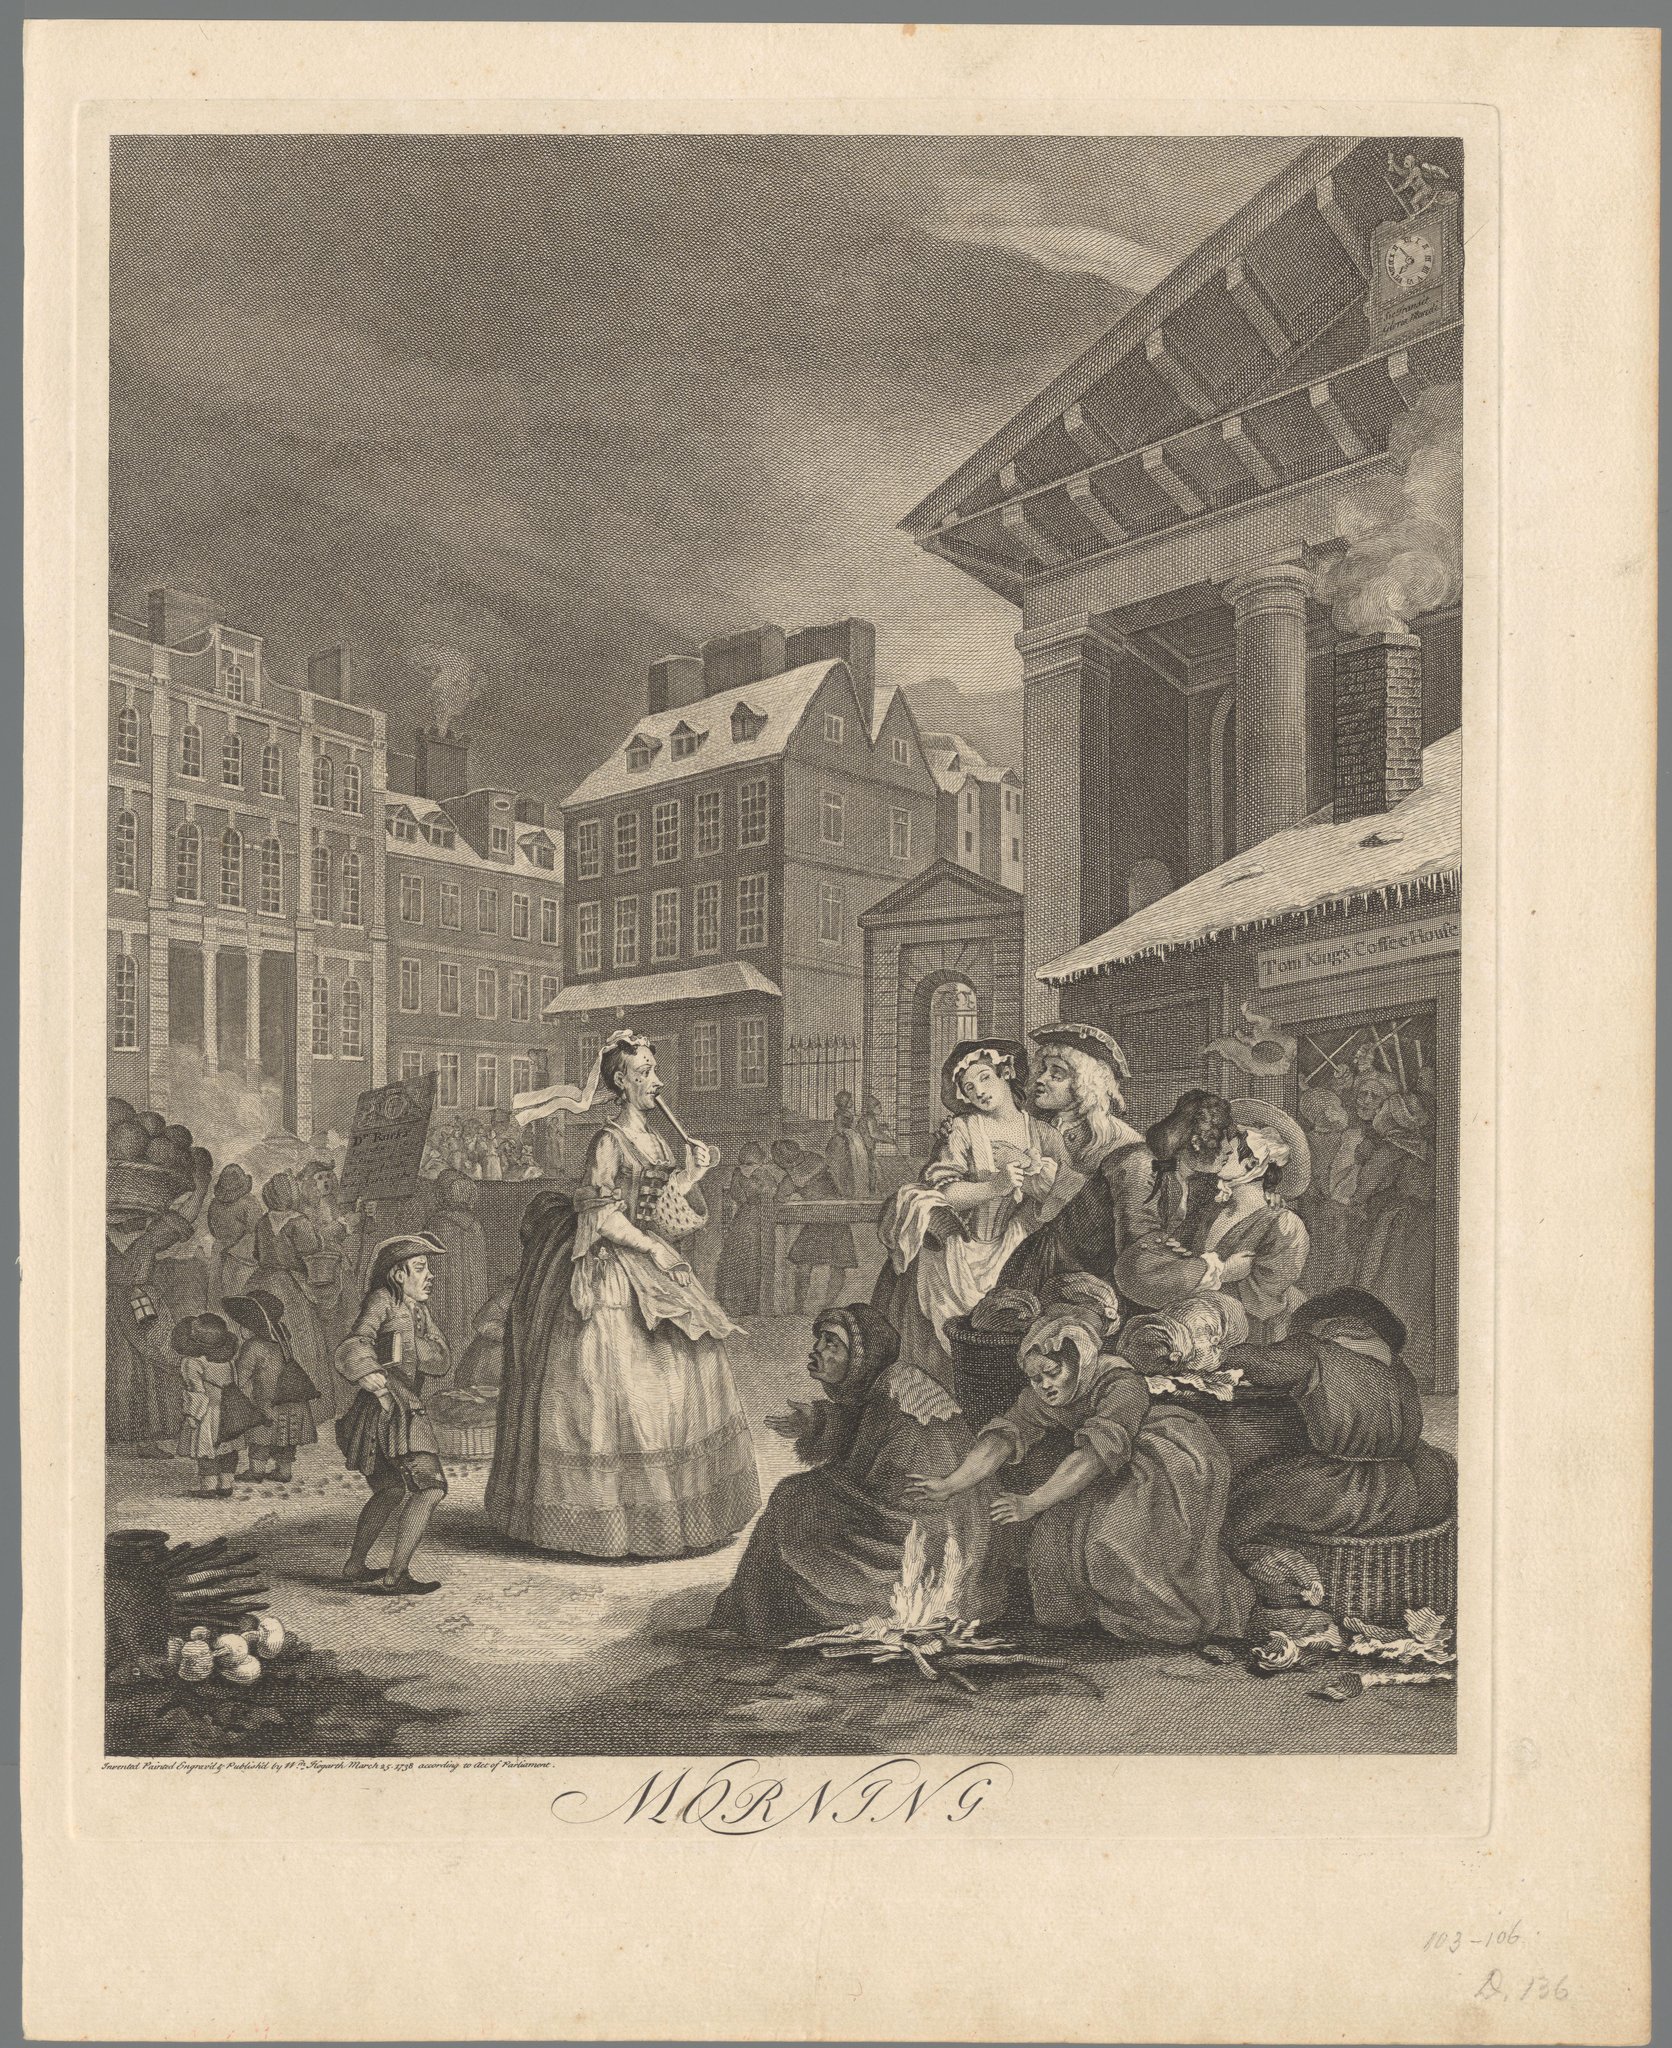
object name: print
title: Morning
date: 1738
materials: paper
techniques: engraving, etching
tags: coldness, morning, winter landscape; landscape symbolizing winter (the four seasons of the year)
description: Een winters ogend Covent Garden met rechts Tom King's Coffee House: een befaamde Londense kroeg die tot in de ochtend open bleef, hier foutief voor Saint Paul's Cathedral weergegeven. Binnen wordt gevochten. Buiten bedelaars bij een kampvuur en minnende stellen die afkeurend worden bekeken door een vrouw die gekleed is naar de Engelse mode en haar loopjongen. Links staat een grote groep mensen om een kwakzalver heen, mogelijk dokter Richard Rock, die een bord met daarop het zegel van koninklijke goedkeuring vasthoudt.